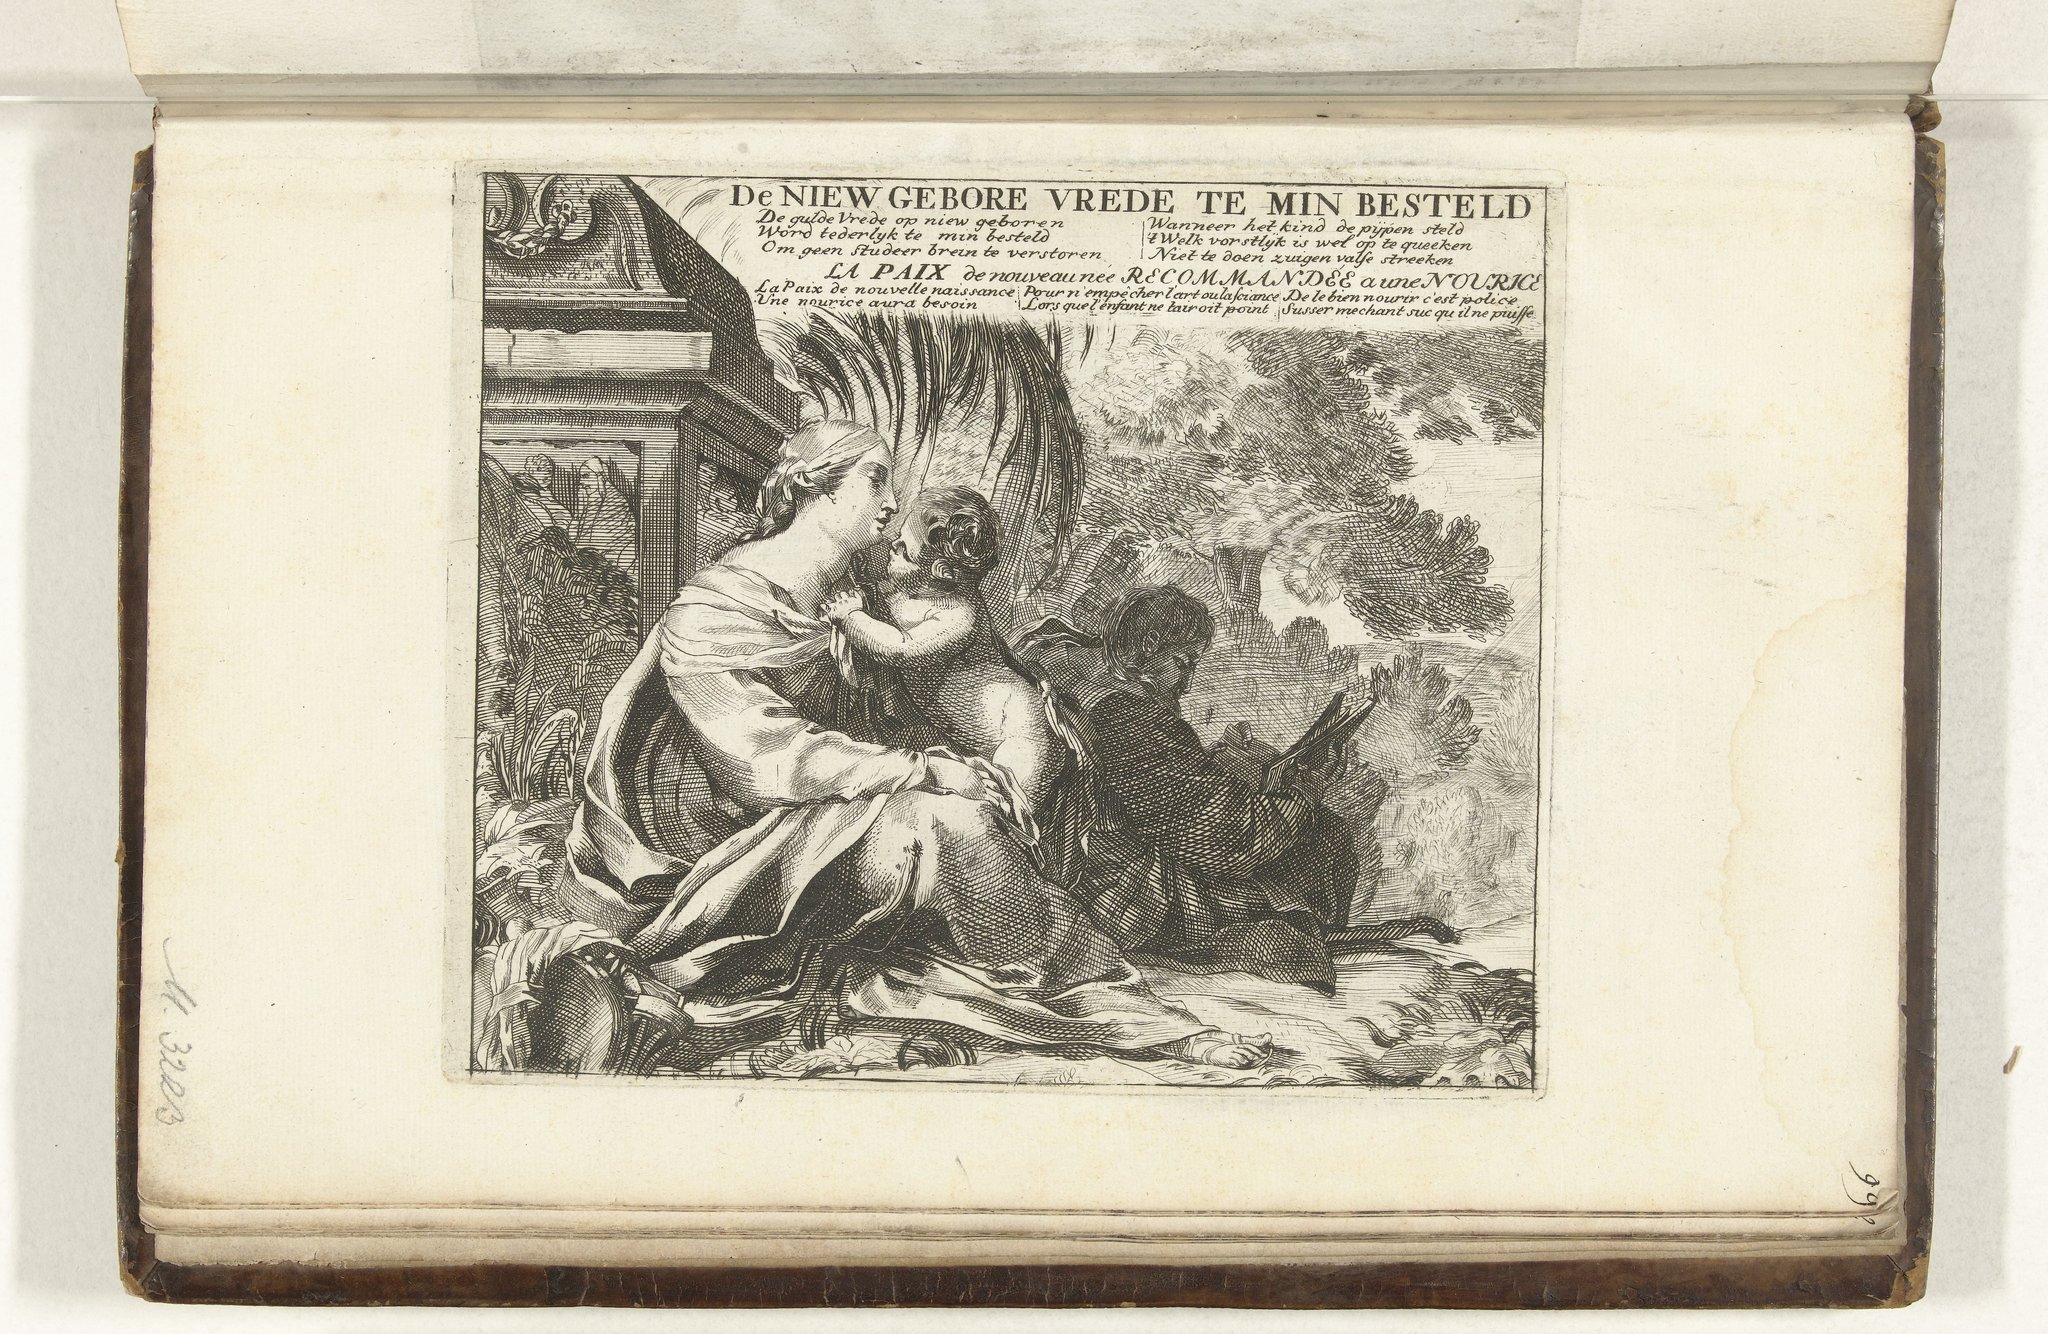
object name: print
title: Platen over de Vrede van Utrecht van 1713 / 't Lusthof van Momus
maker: abraham allard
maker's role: print maker, publisher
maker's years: 1676-1725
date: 1713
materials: paper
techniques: engraving, etching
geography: amsterdam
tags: rest on the flight into egypt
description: Allegorie op de nieuwgeboren vrede. De heilige Familie op de rust tijdens de vlucht naar Egypte. Maria met het Christuskind op schoot geleund tegen een monument, rechts de lezende Jozef. Allegorie waarin het Christuskind de rol vervult van de jonge Vrede van Utrecht, 1713. In de plaat verzen in het Nederlands en Frans. Onderdeel van een groep van 28 nieuwe en oude platen aangepast ter illustratie van de Vrede van Utrecht in 1713. Onderdeel van het prentwerk uitgegeven onder de verzameltitel 't Lust-Hof van Momus met de gebundelde series van spotprenten tijdens de jaren 1701-1713 van de Spaanse Successieoorlog.